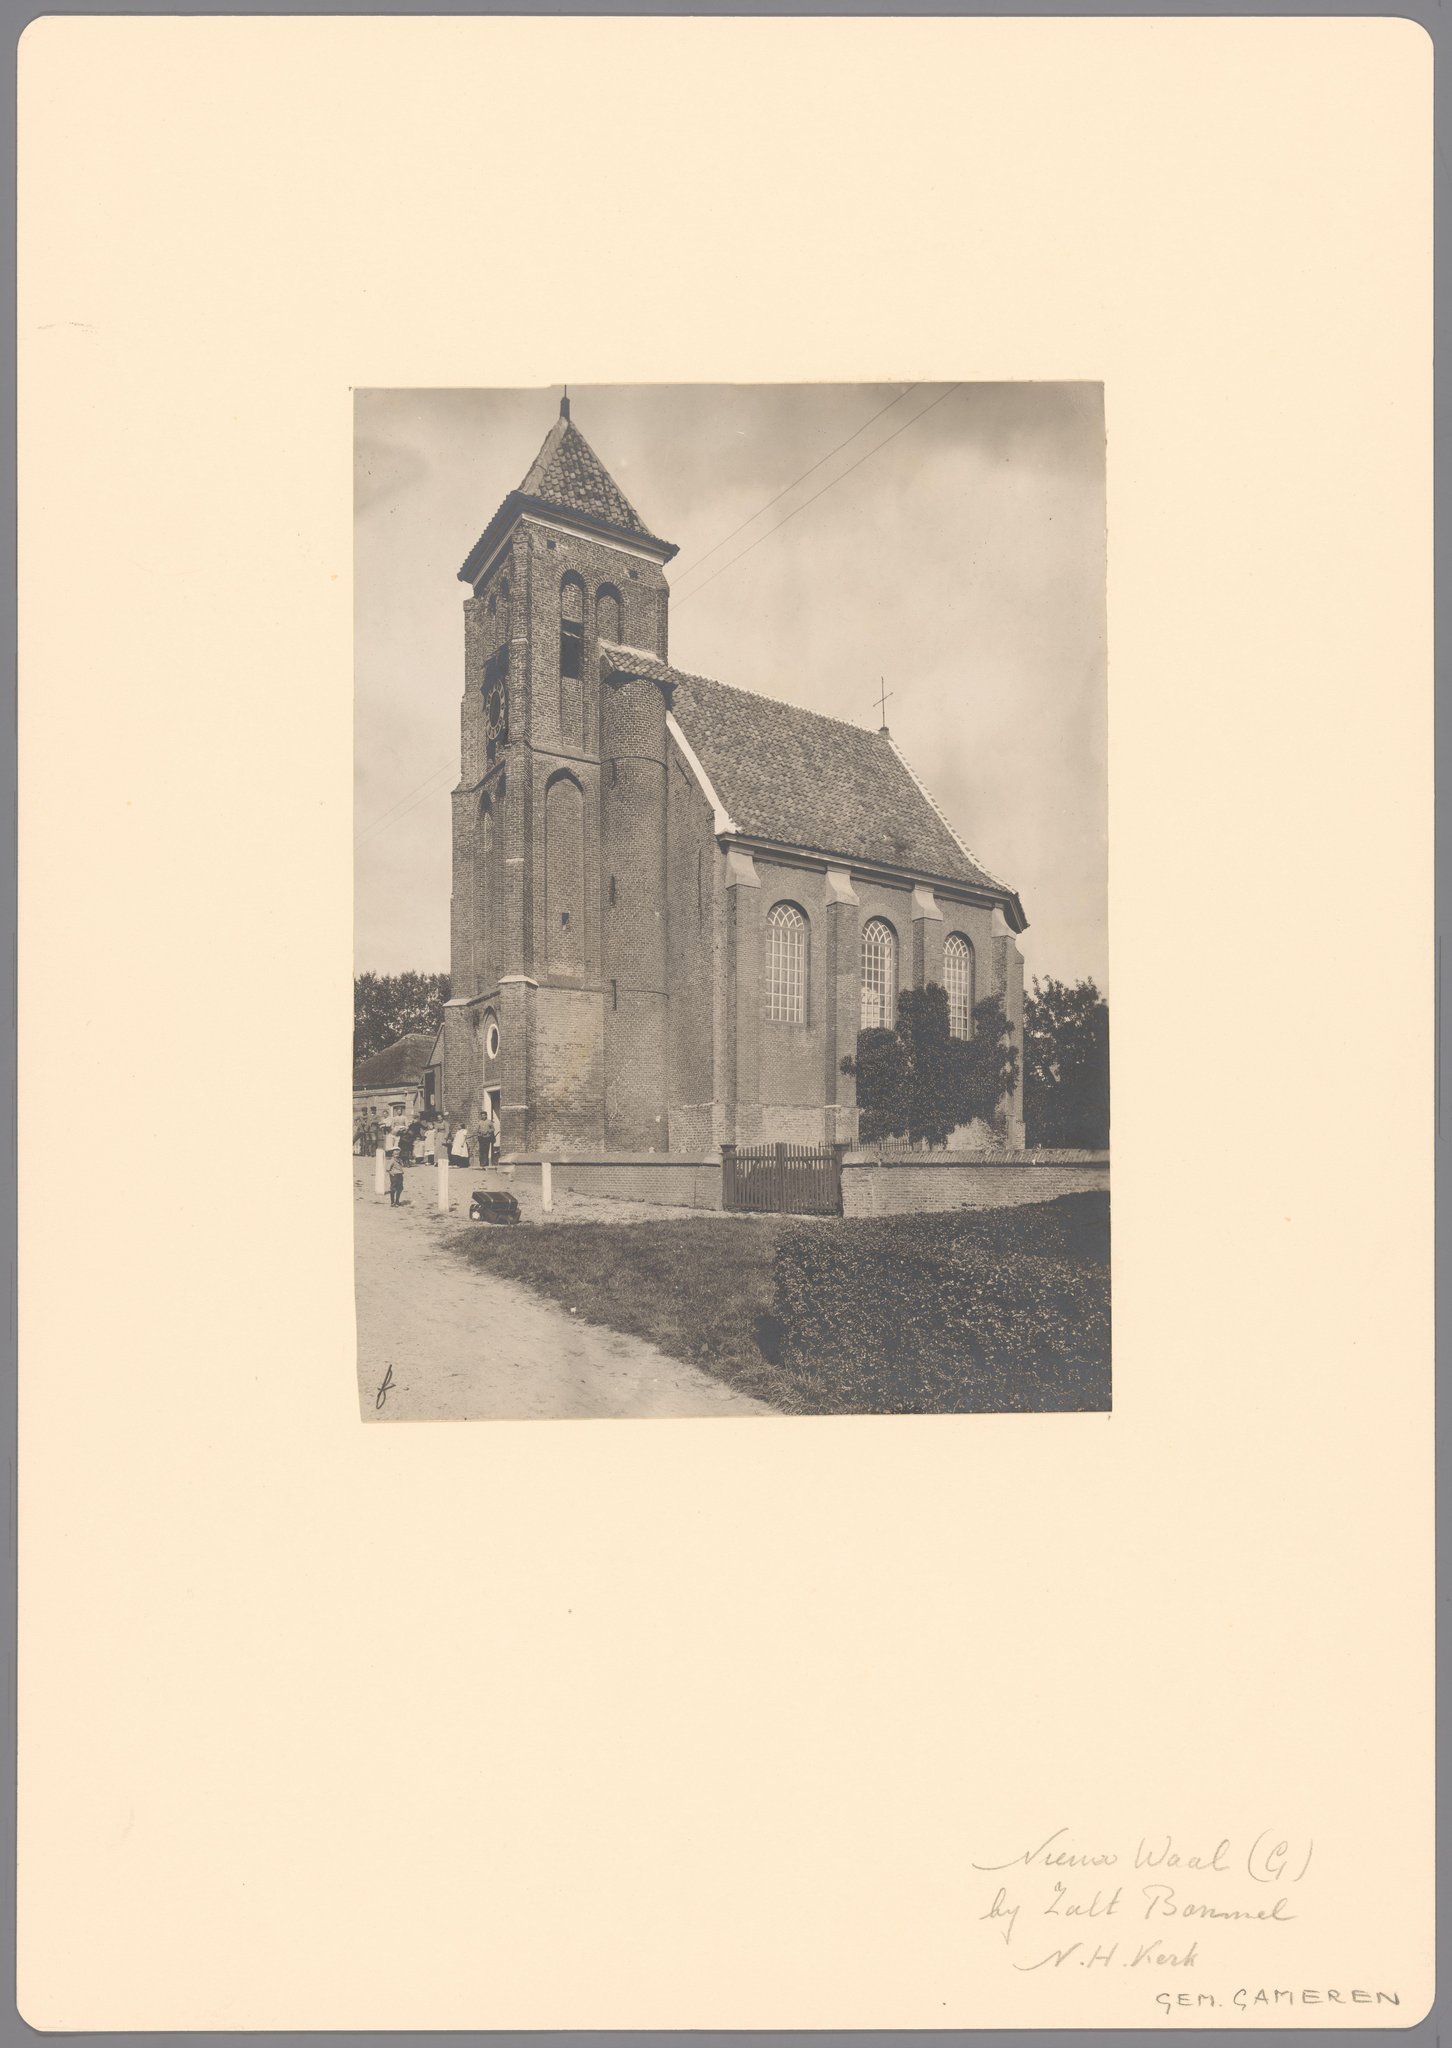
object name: photograph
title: Gezicht op de Hervormde Kerk te Nieuwaal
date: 1907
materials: cardboard, photographic support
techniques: gelatin silver print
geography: nieuwaal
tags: church (exterior), village street (+ city(-scape) with figures, staffage)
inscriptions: annotation: ‘F/ Nieuw Waal (G) / bij Zalt Bommel / N.H. Kerk / GEM. GAMEREN’